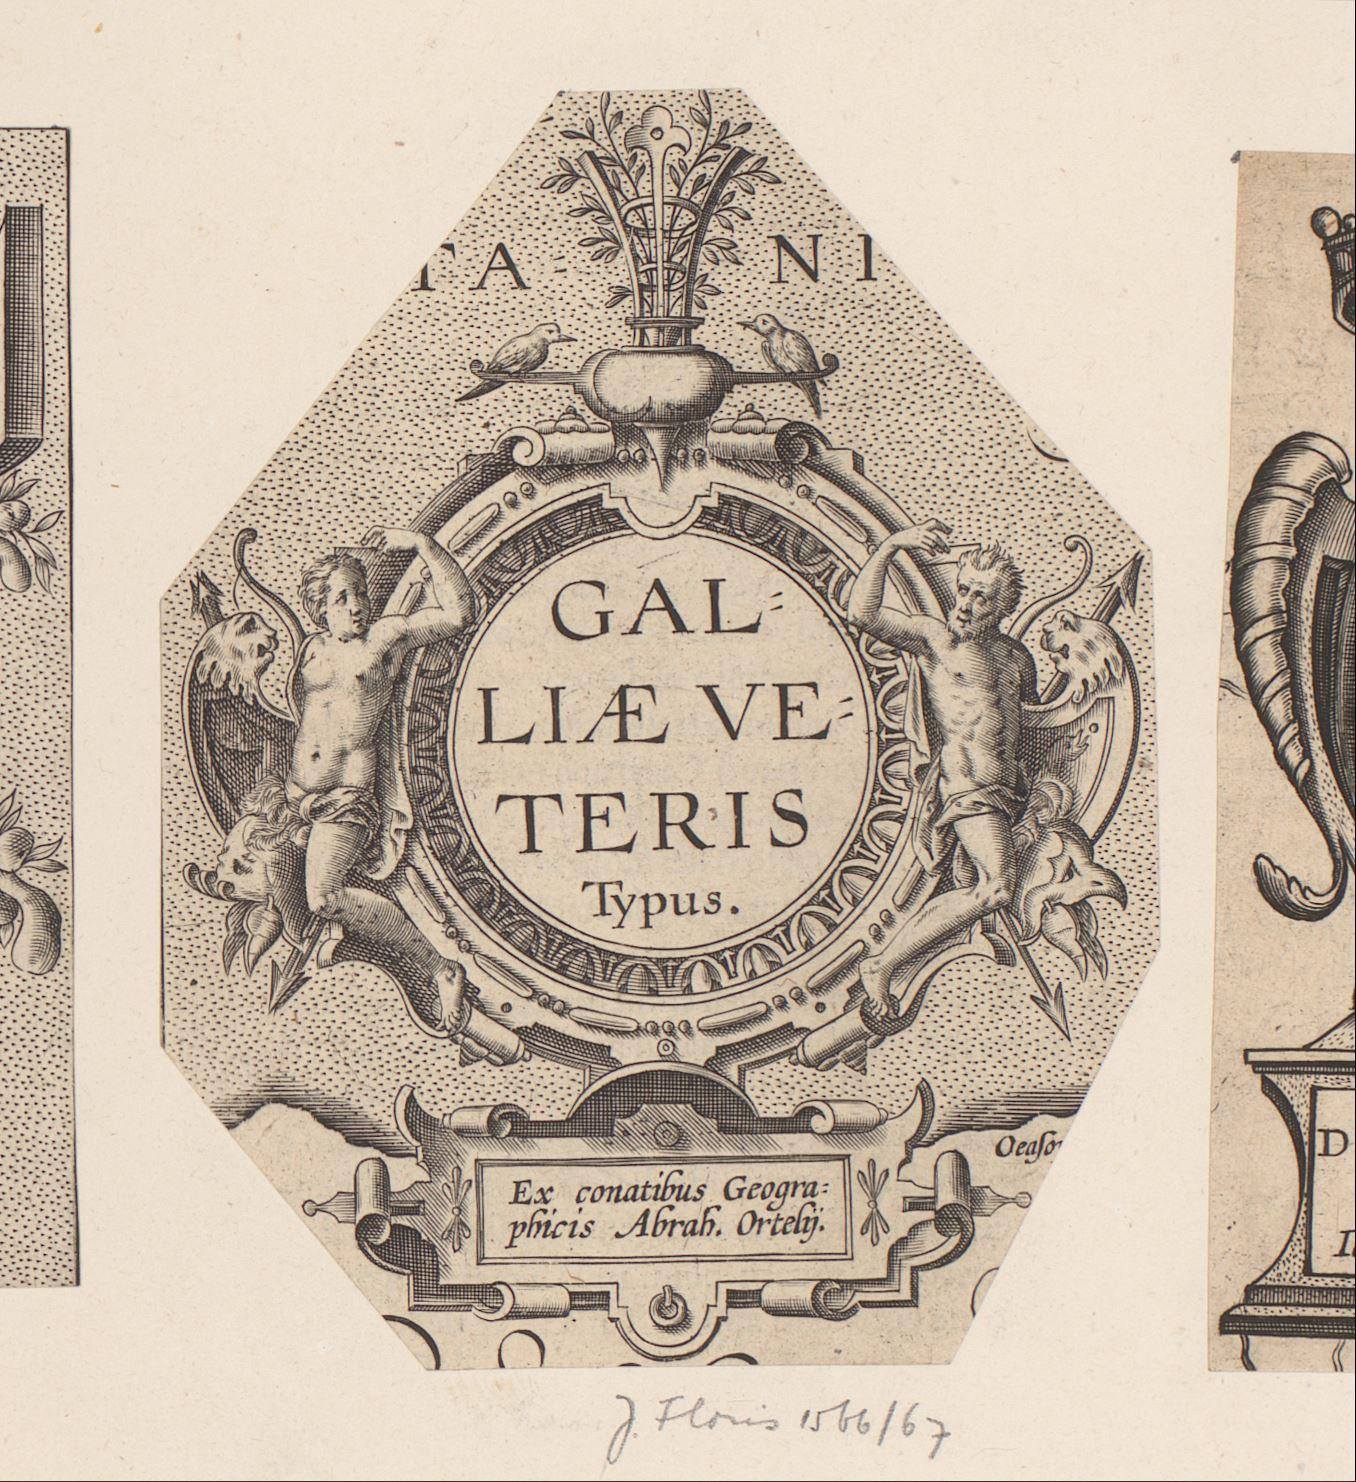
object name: album leaf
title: Theatrum Orbis Terrarum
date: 1595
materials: paper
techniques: engraving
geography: antwerp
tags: sitting figure, ornament ~ cartouche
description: Cartouche in twee delen. Het ronde gedeelte wordt geflankeerd door twee manfiguren met pijl en boog. De cartouche is een fragment van een kaart van Frankrijk. De prent maakt deel uit van een album.